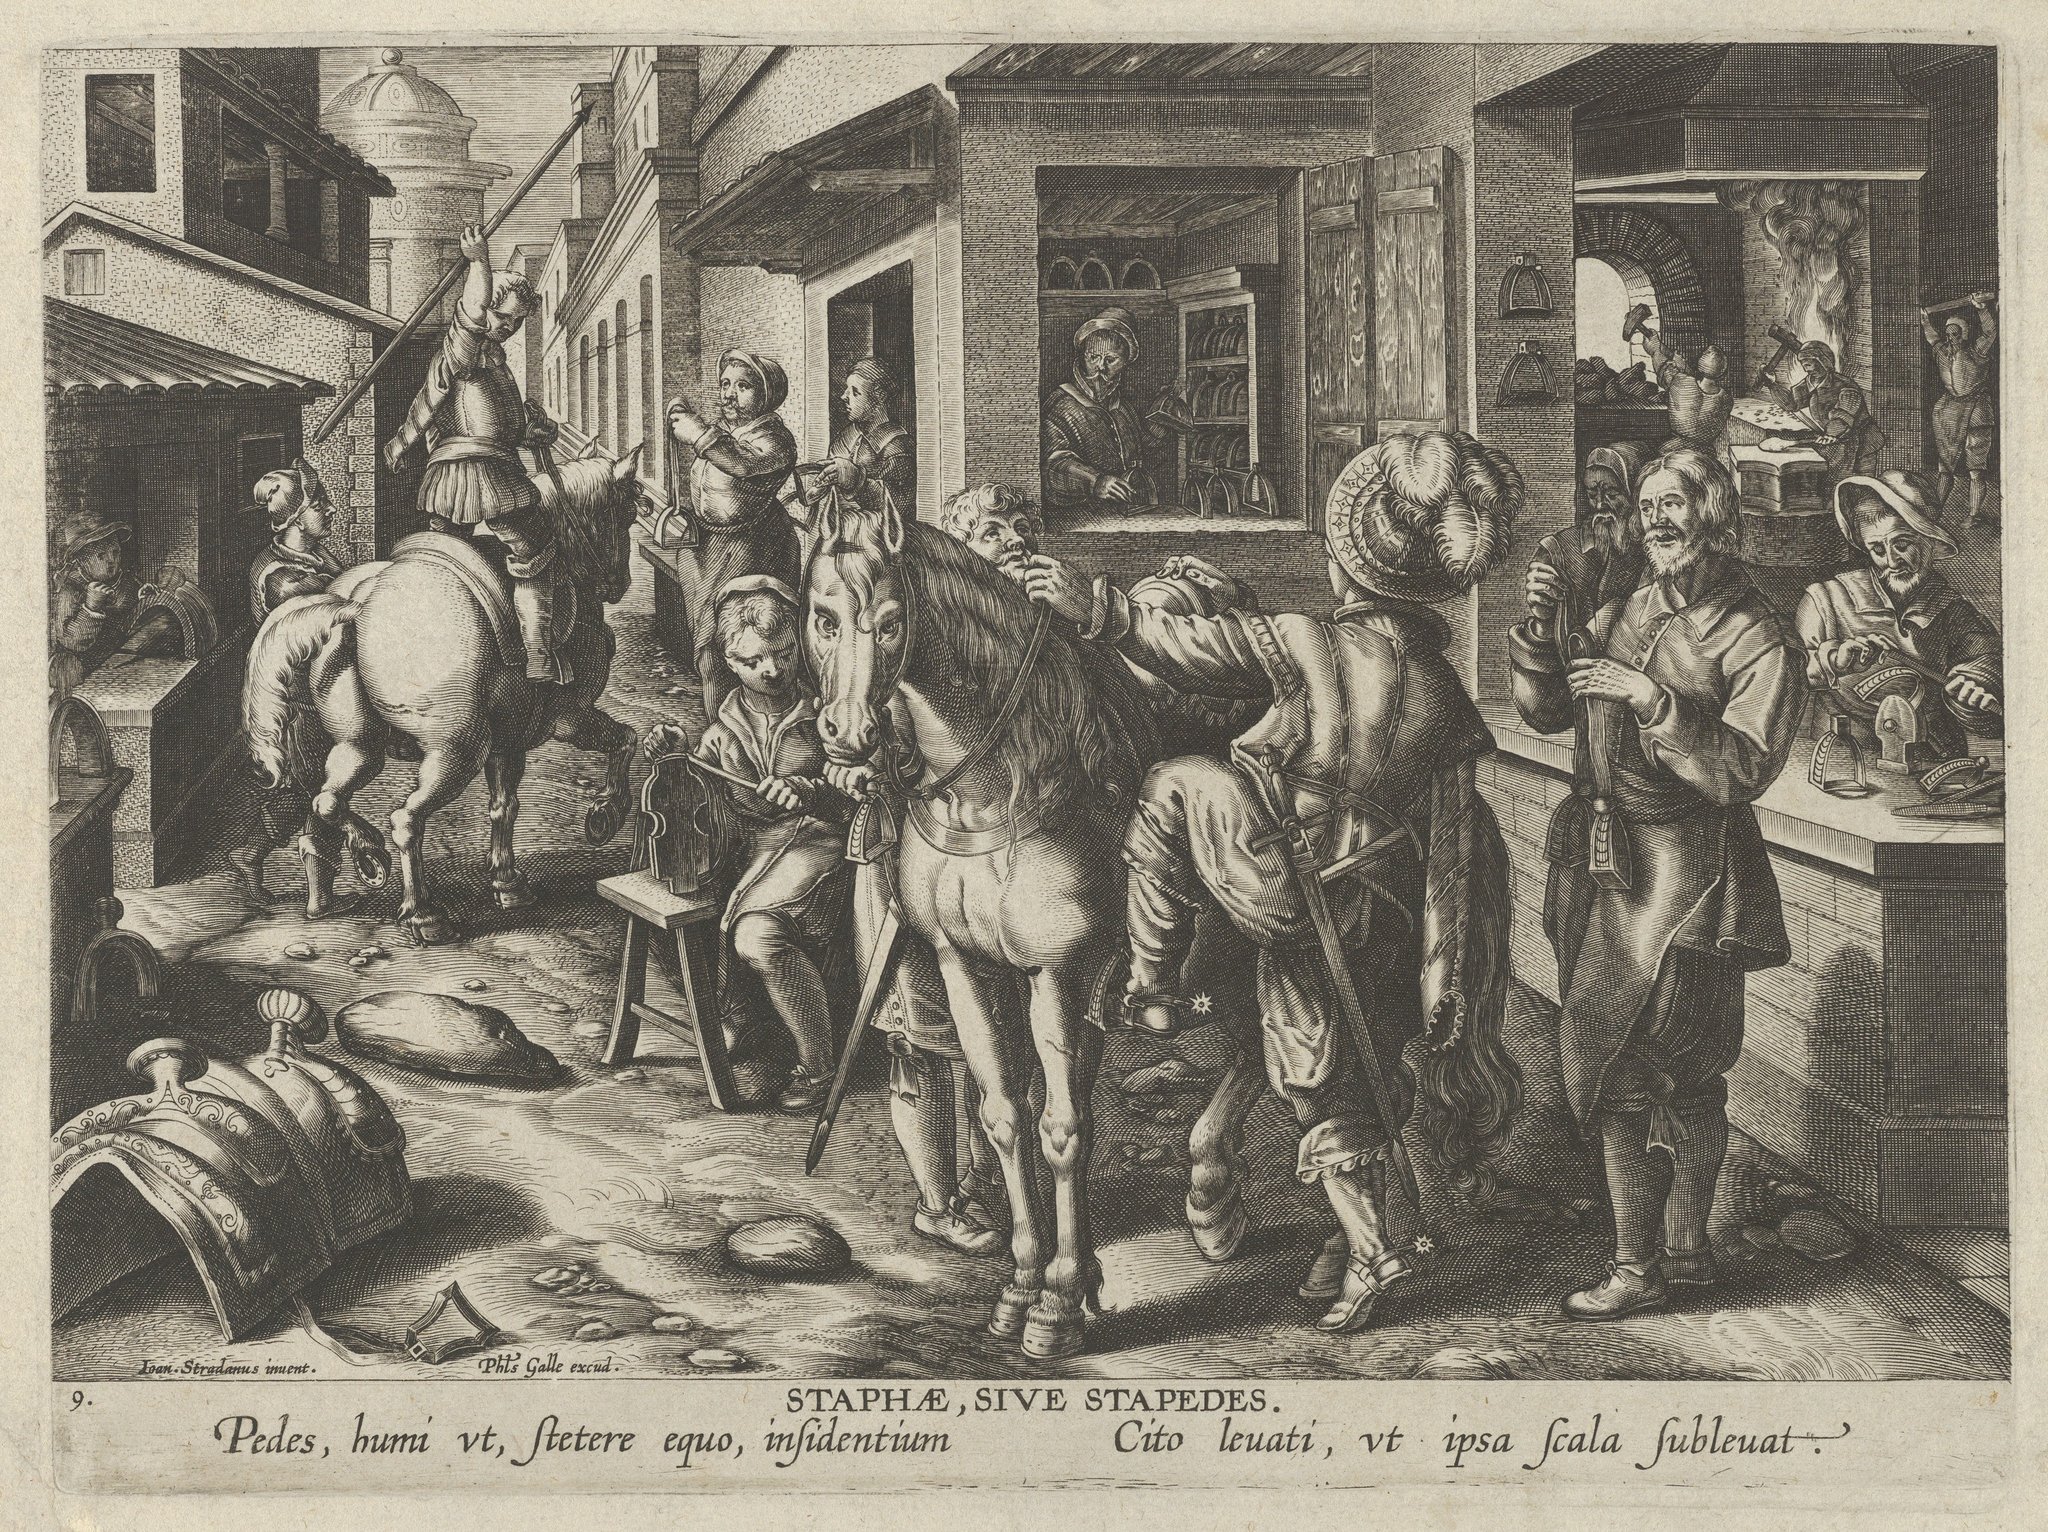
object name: print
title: New Inventions of Modern Times [Nova Reperta], The Invention of Stirrups, plate 9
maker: jan collaert i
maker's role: artist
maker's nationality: netherlandish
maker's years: 1530-1581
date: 1600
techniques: engraving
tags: soldiers,men,horses